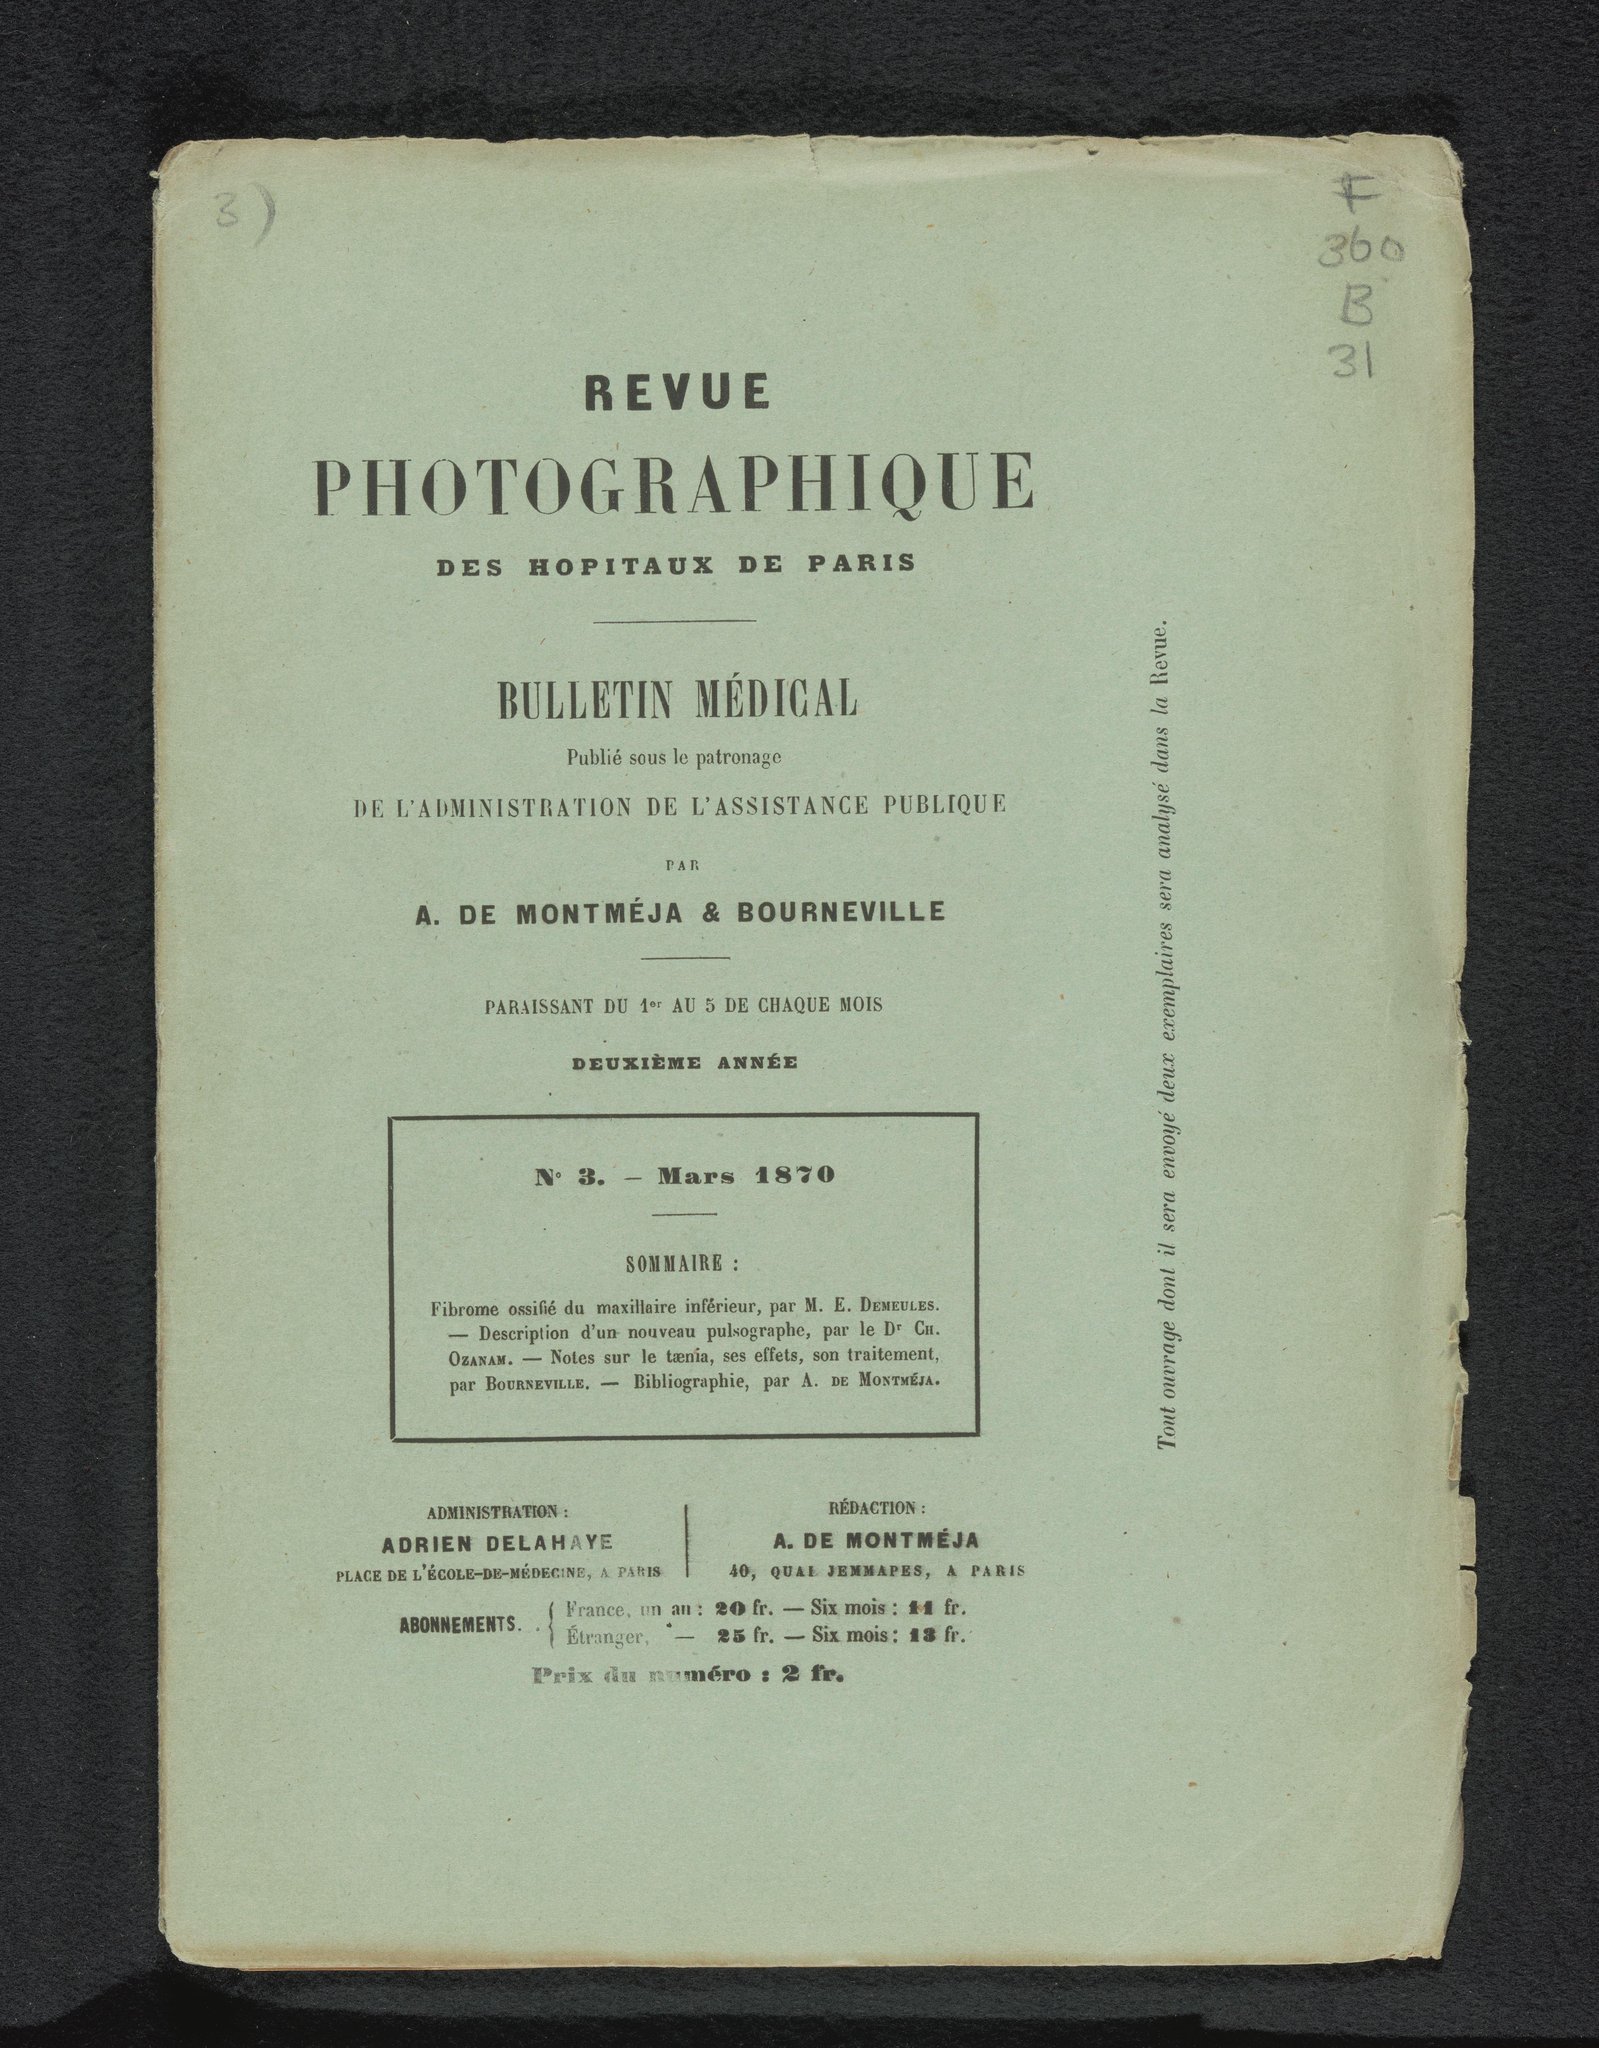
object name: magazine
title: Revue photographique des hôpitaux de Paris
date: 1870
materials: paper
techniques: printing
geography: paris